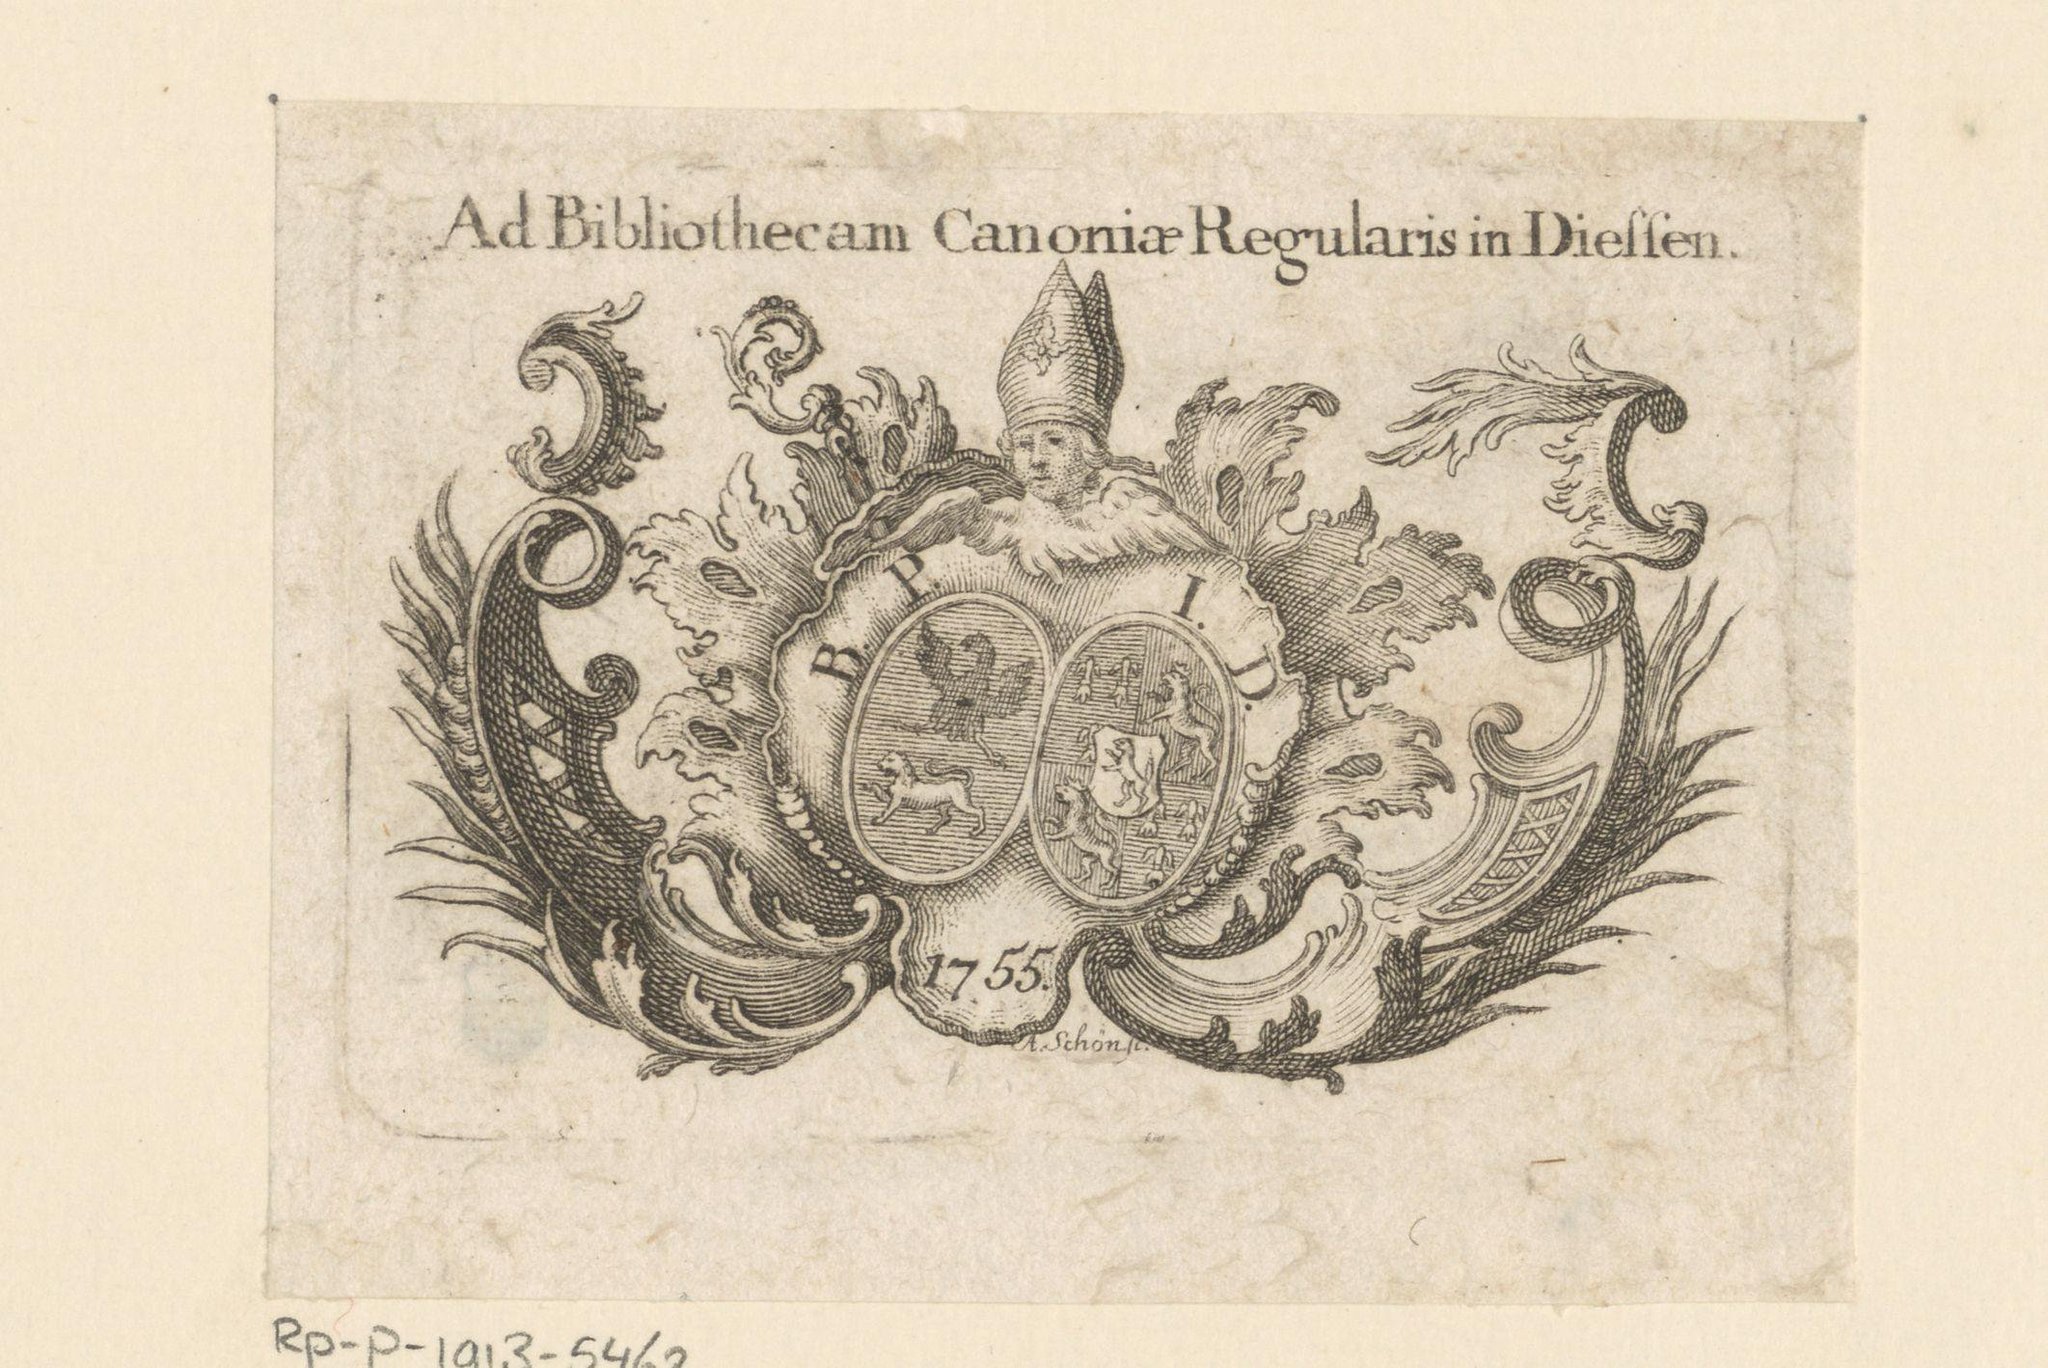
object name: bookplate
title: Ex libris van Ad Bibliothecam Canoniae Regularis in Diessen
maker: a. schön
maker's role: print maker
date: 1755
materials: paper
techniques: engraving, etching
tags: armorial bearing, heraldry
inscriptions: collector's mark: Lugt 2760, collector's mark: Lugt 2233